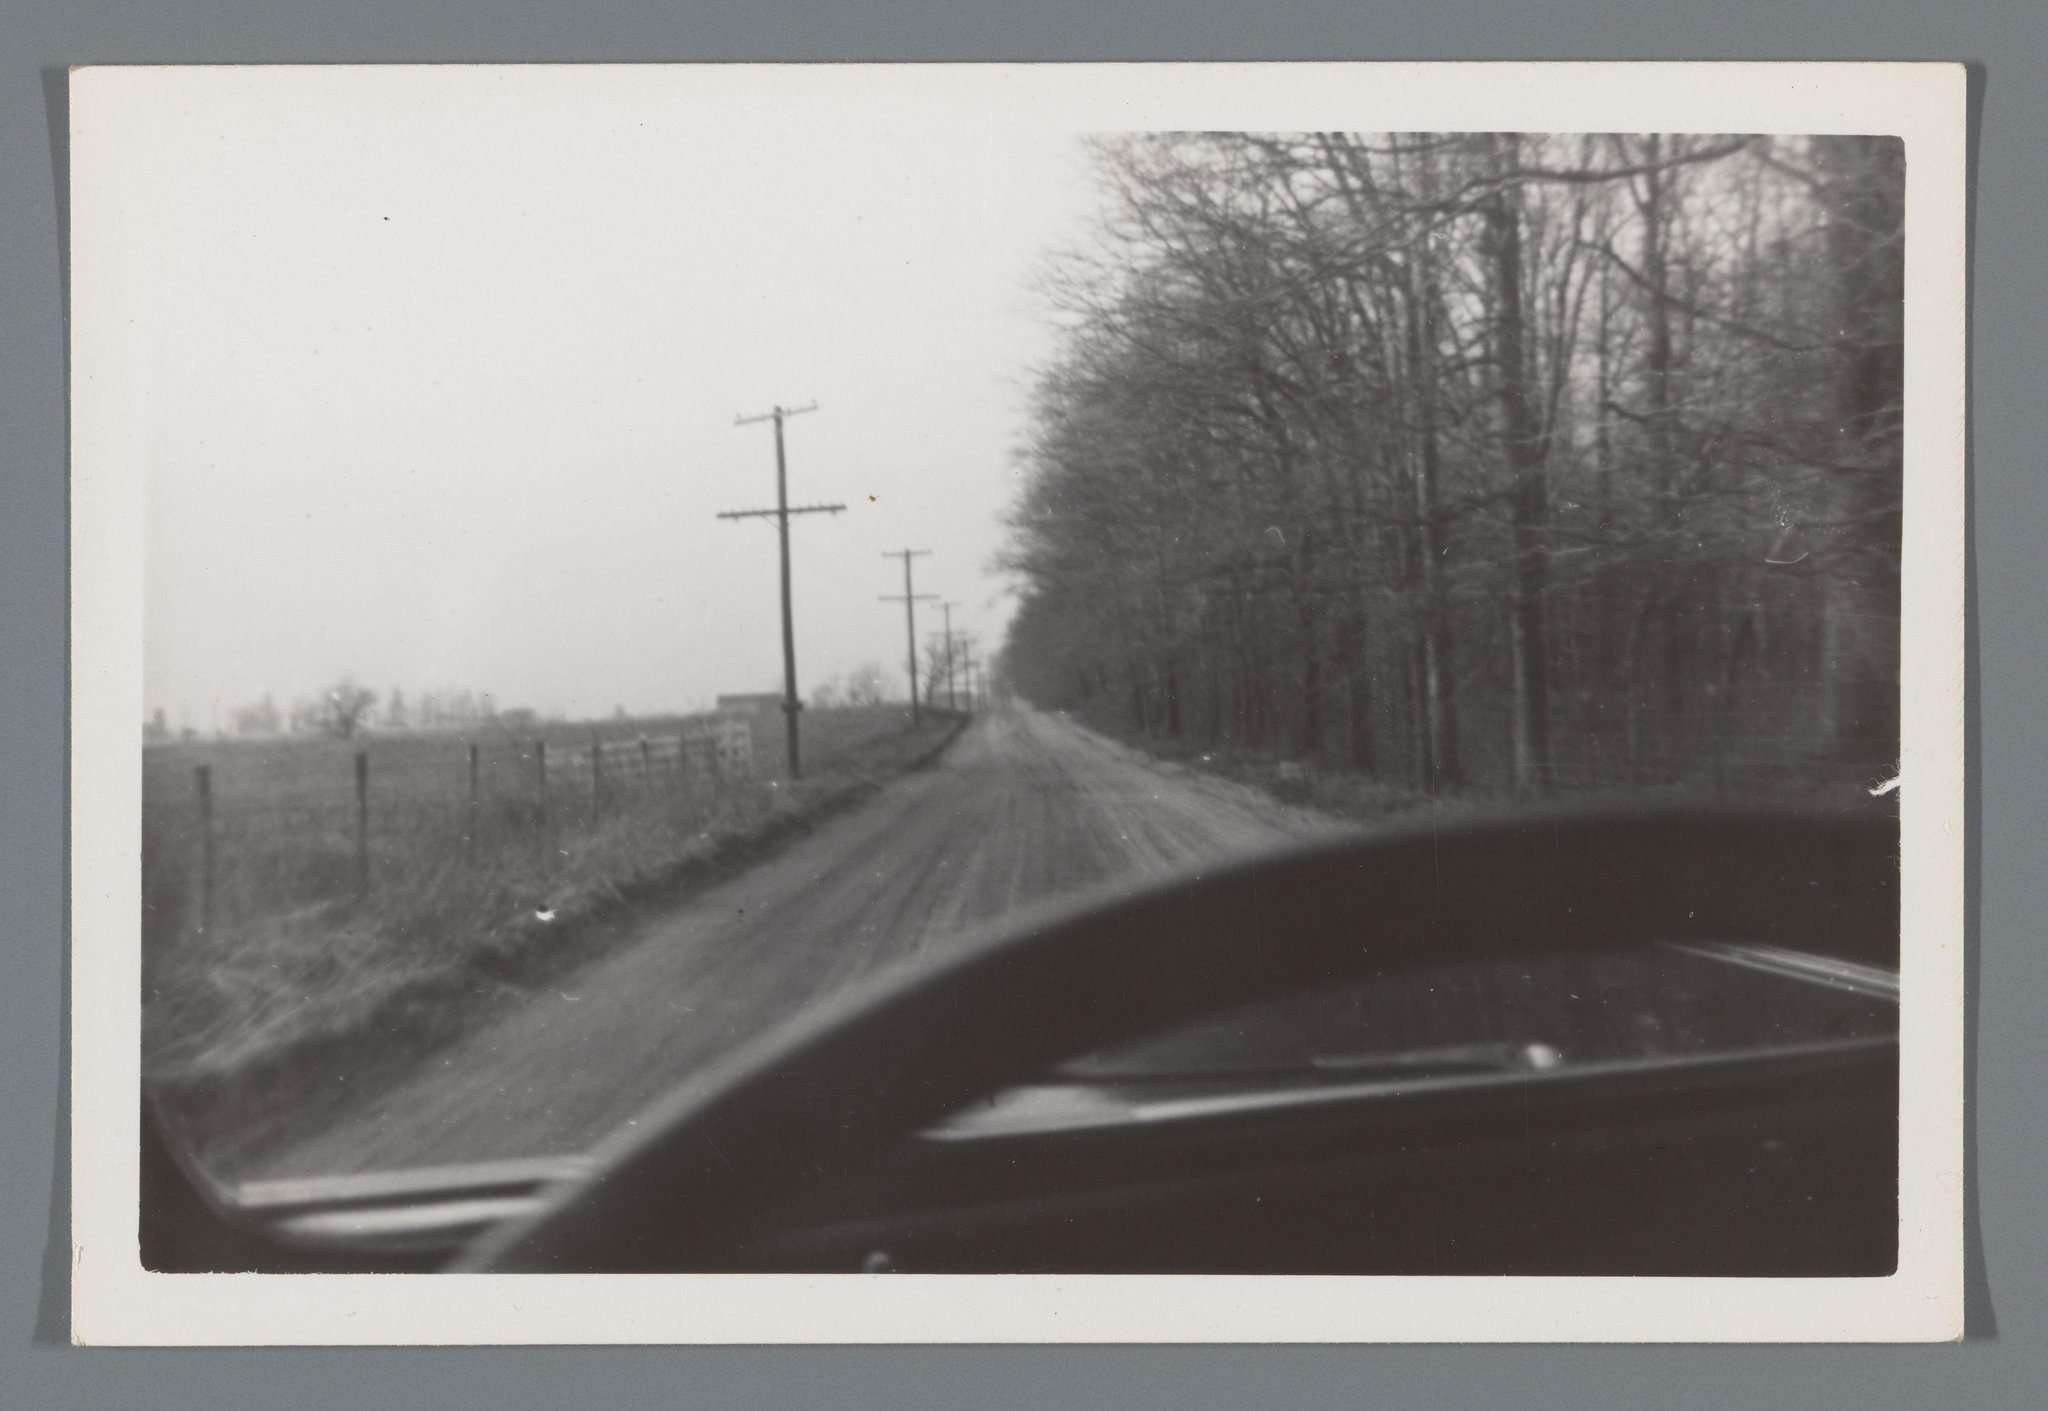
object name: photograph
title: Gezicht vanuit een rijdende auto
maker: Anonymous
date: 1935-1950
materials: paper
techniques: gelatin silver print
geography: united states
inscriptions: inscription: ‘[…]H602’